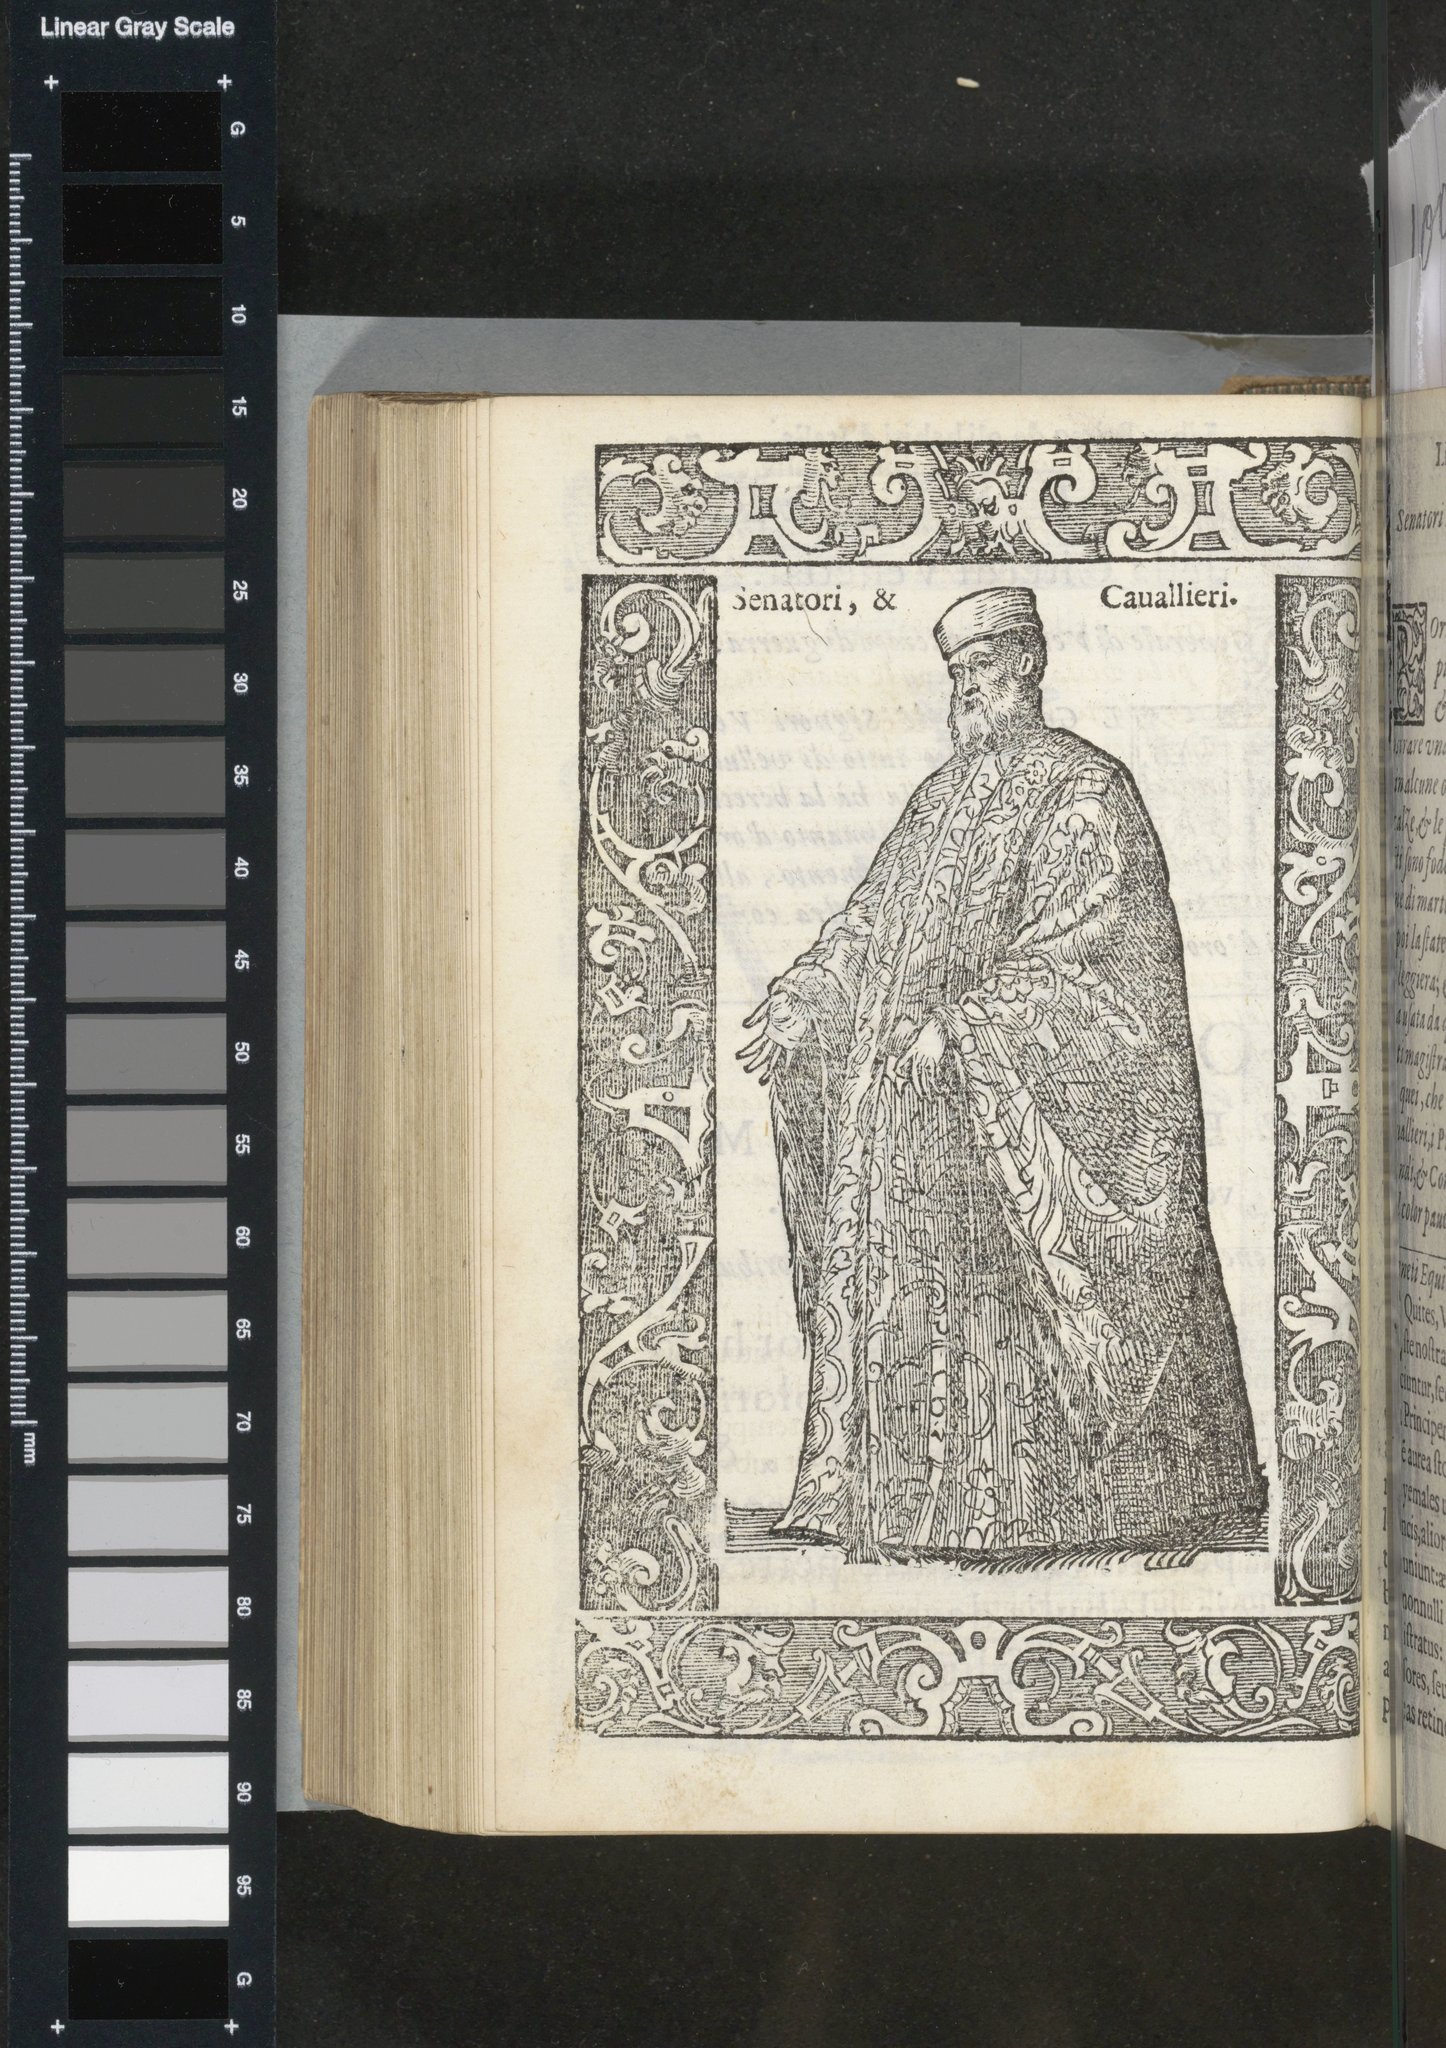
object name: costume print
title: Senatori, & cavallieri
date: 1598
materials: paper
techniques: woodcut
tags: fashion plates